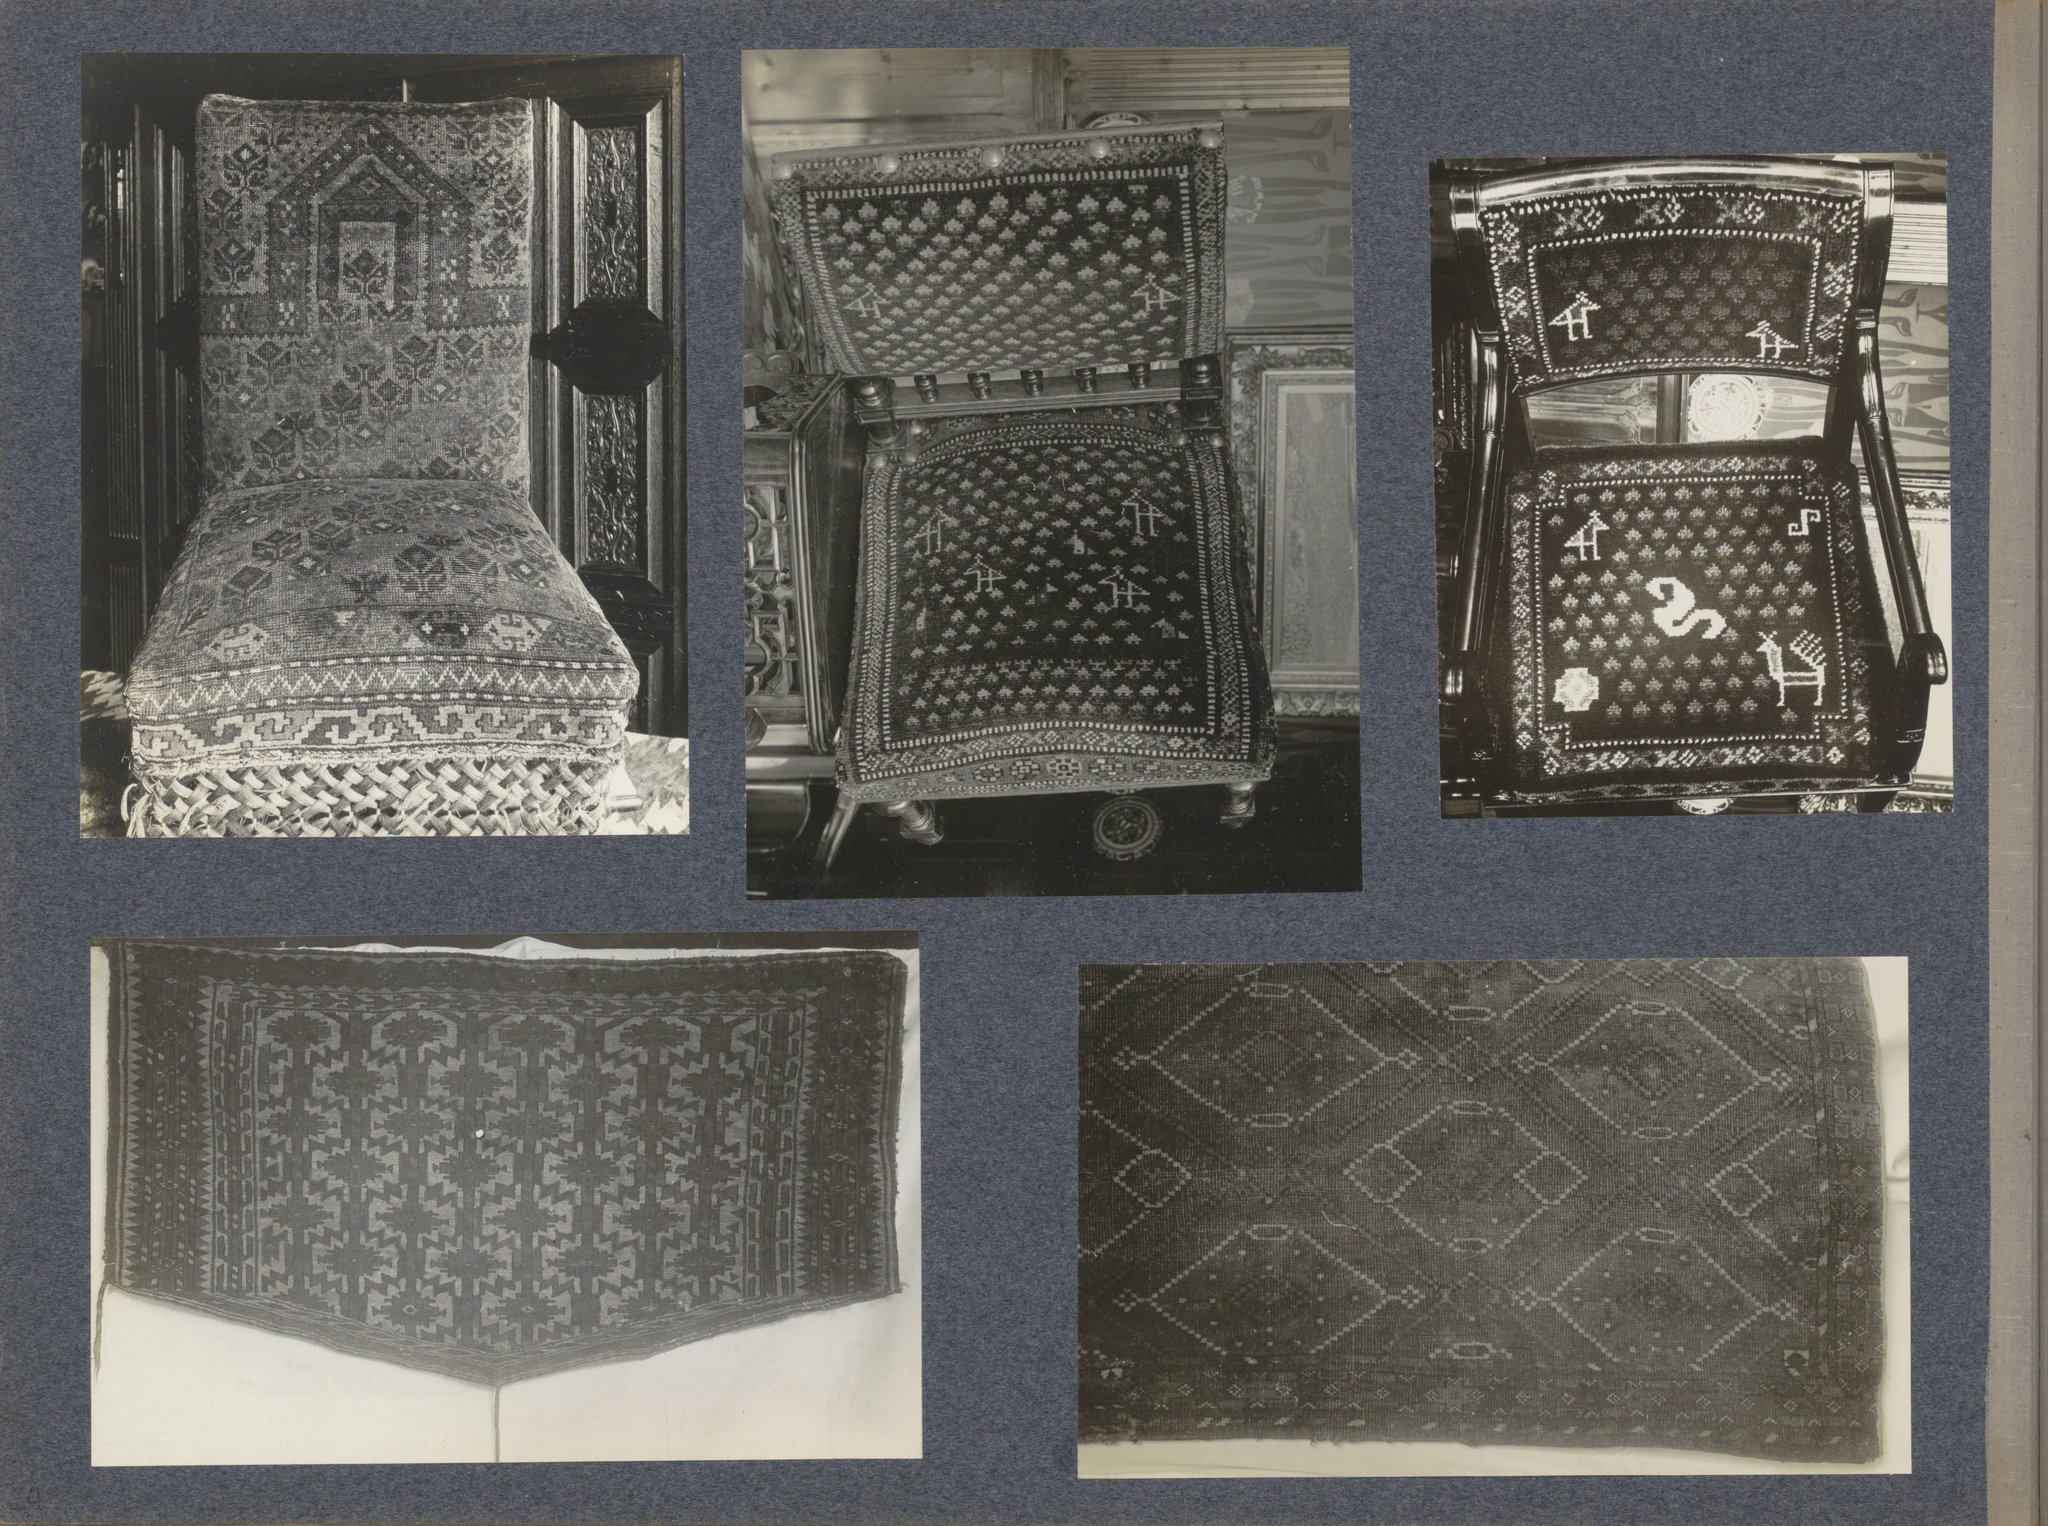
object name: photograph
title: Tapijten (3)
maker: Anonymous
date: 1910-1911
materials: cardboard, paper, photographic support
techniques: gelatin silver print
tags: armchair, seat, carpet, rug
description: Albumblad met vijf foto's van tapijten en beklede stoelen. Onderdeel van Fotoalbum van de familie Palthe uit Almelo.